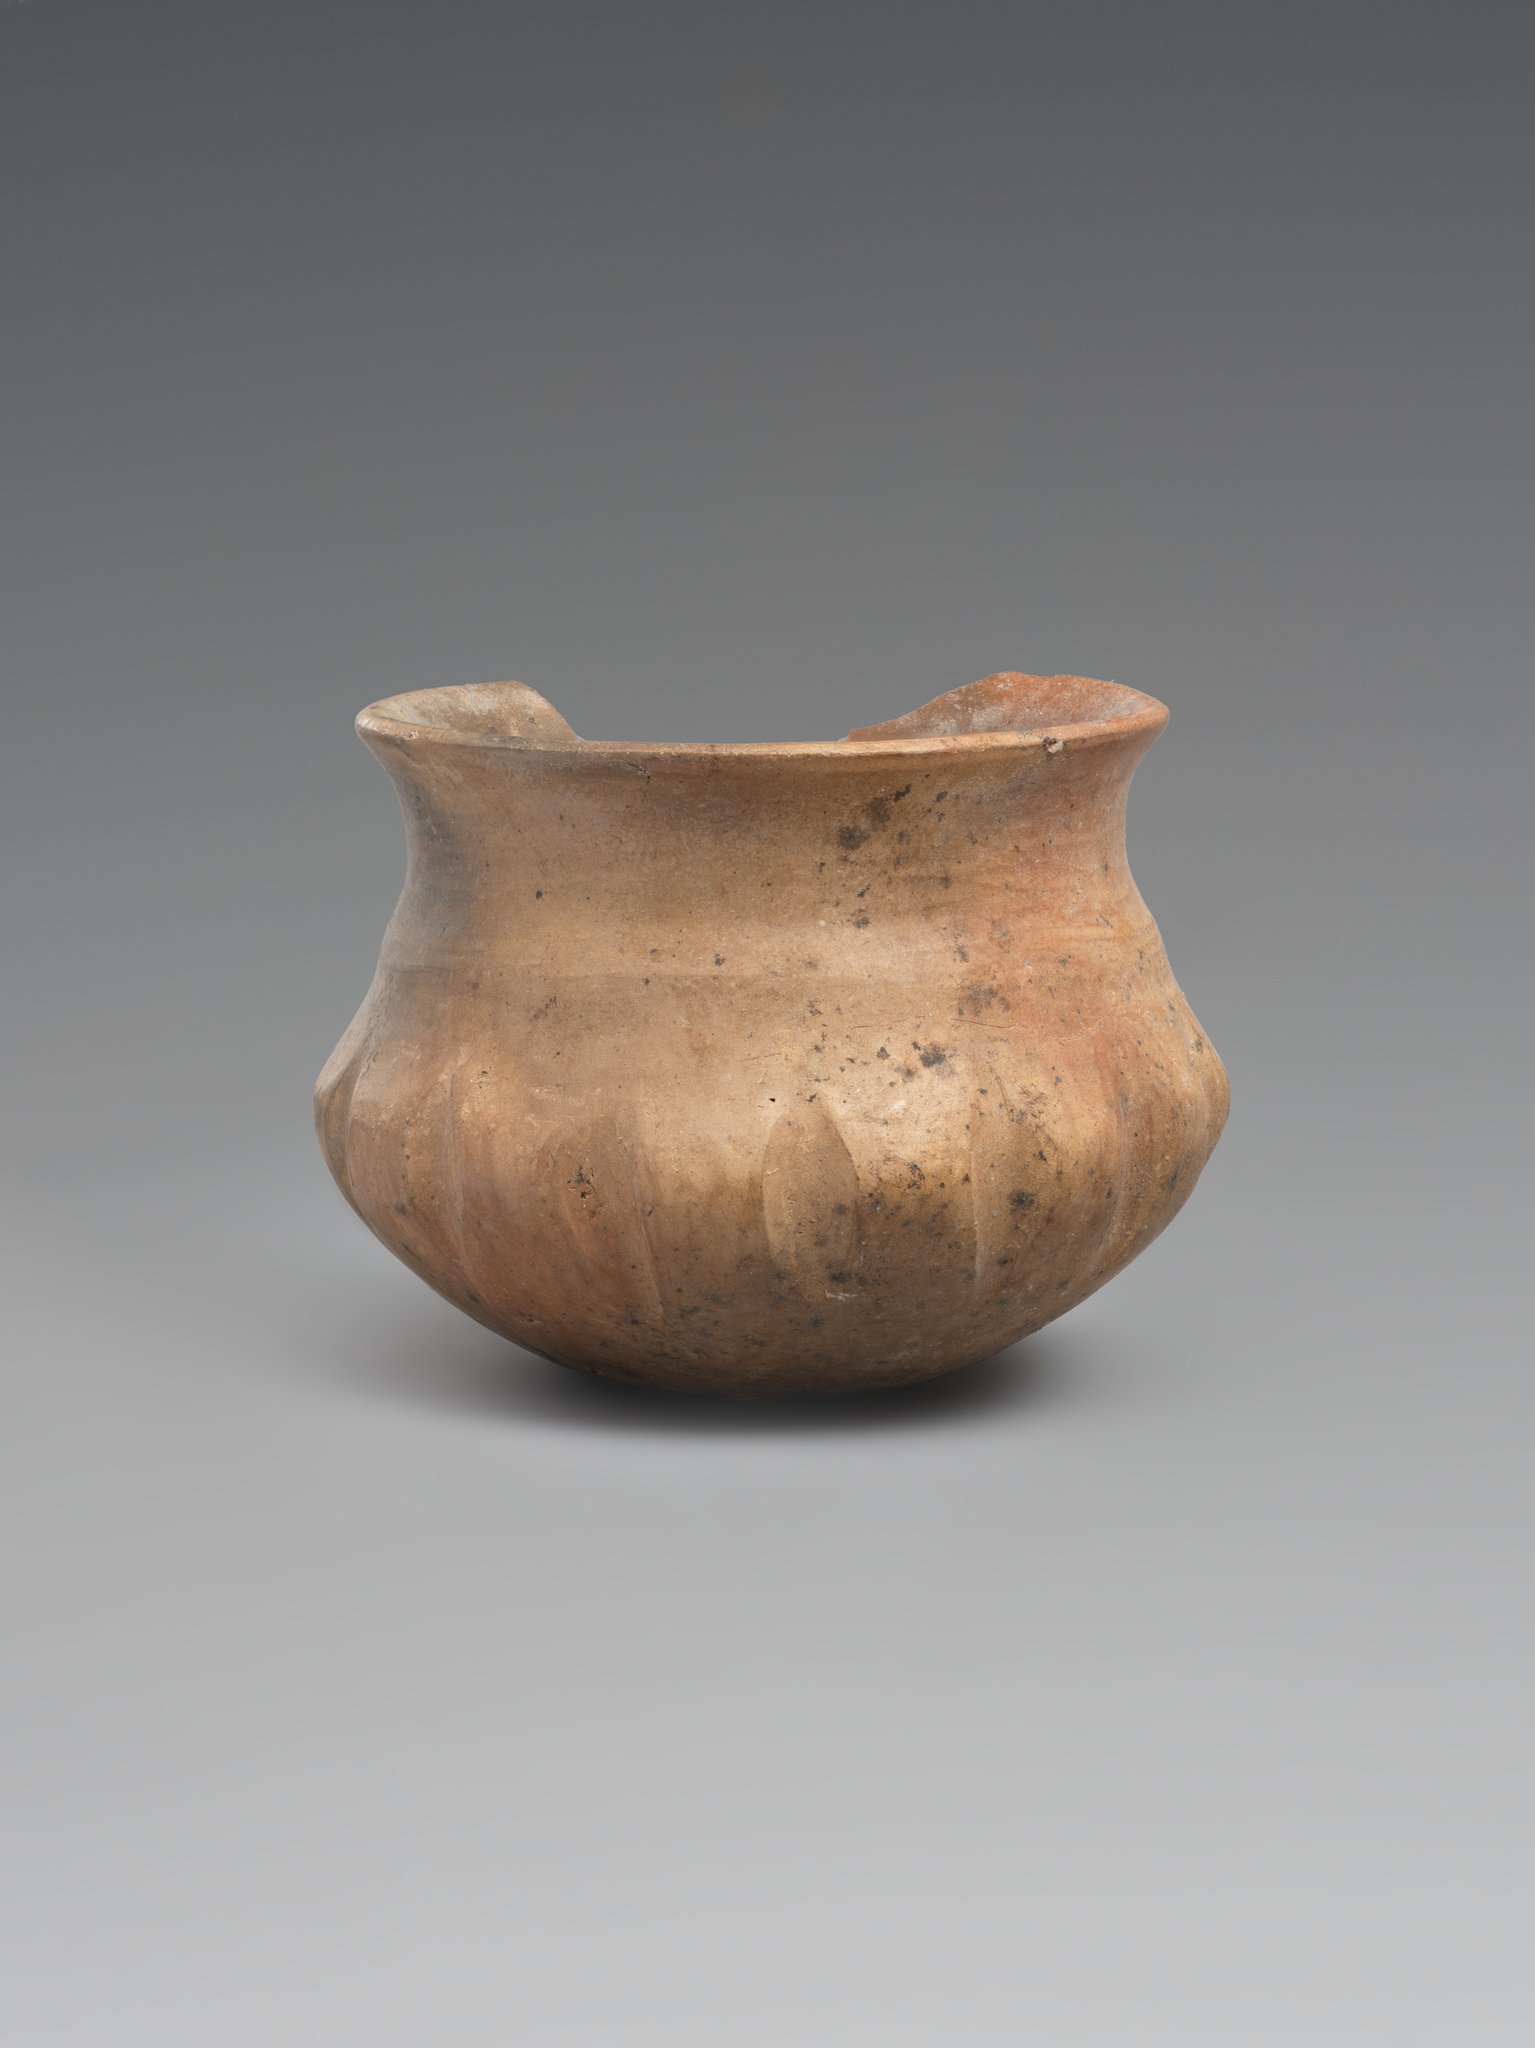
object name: jar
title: Miniature jar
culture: iranian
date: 900-801 BCE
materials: ceramic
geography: iran